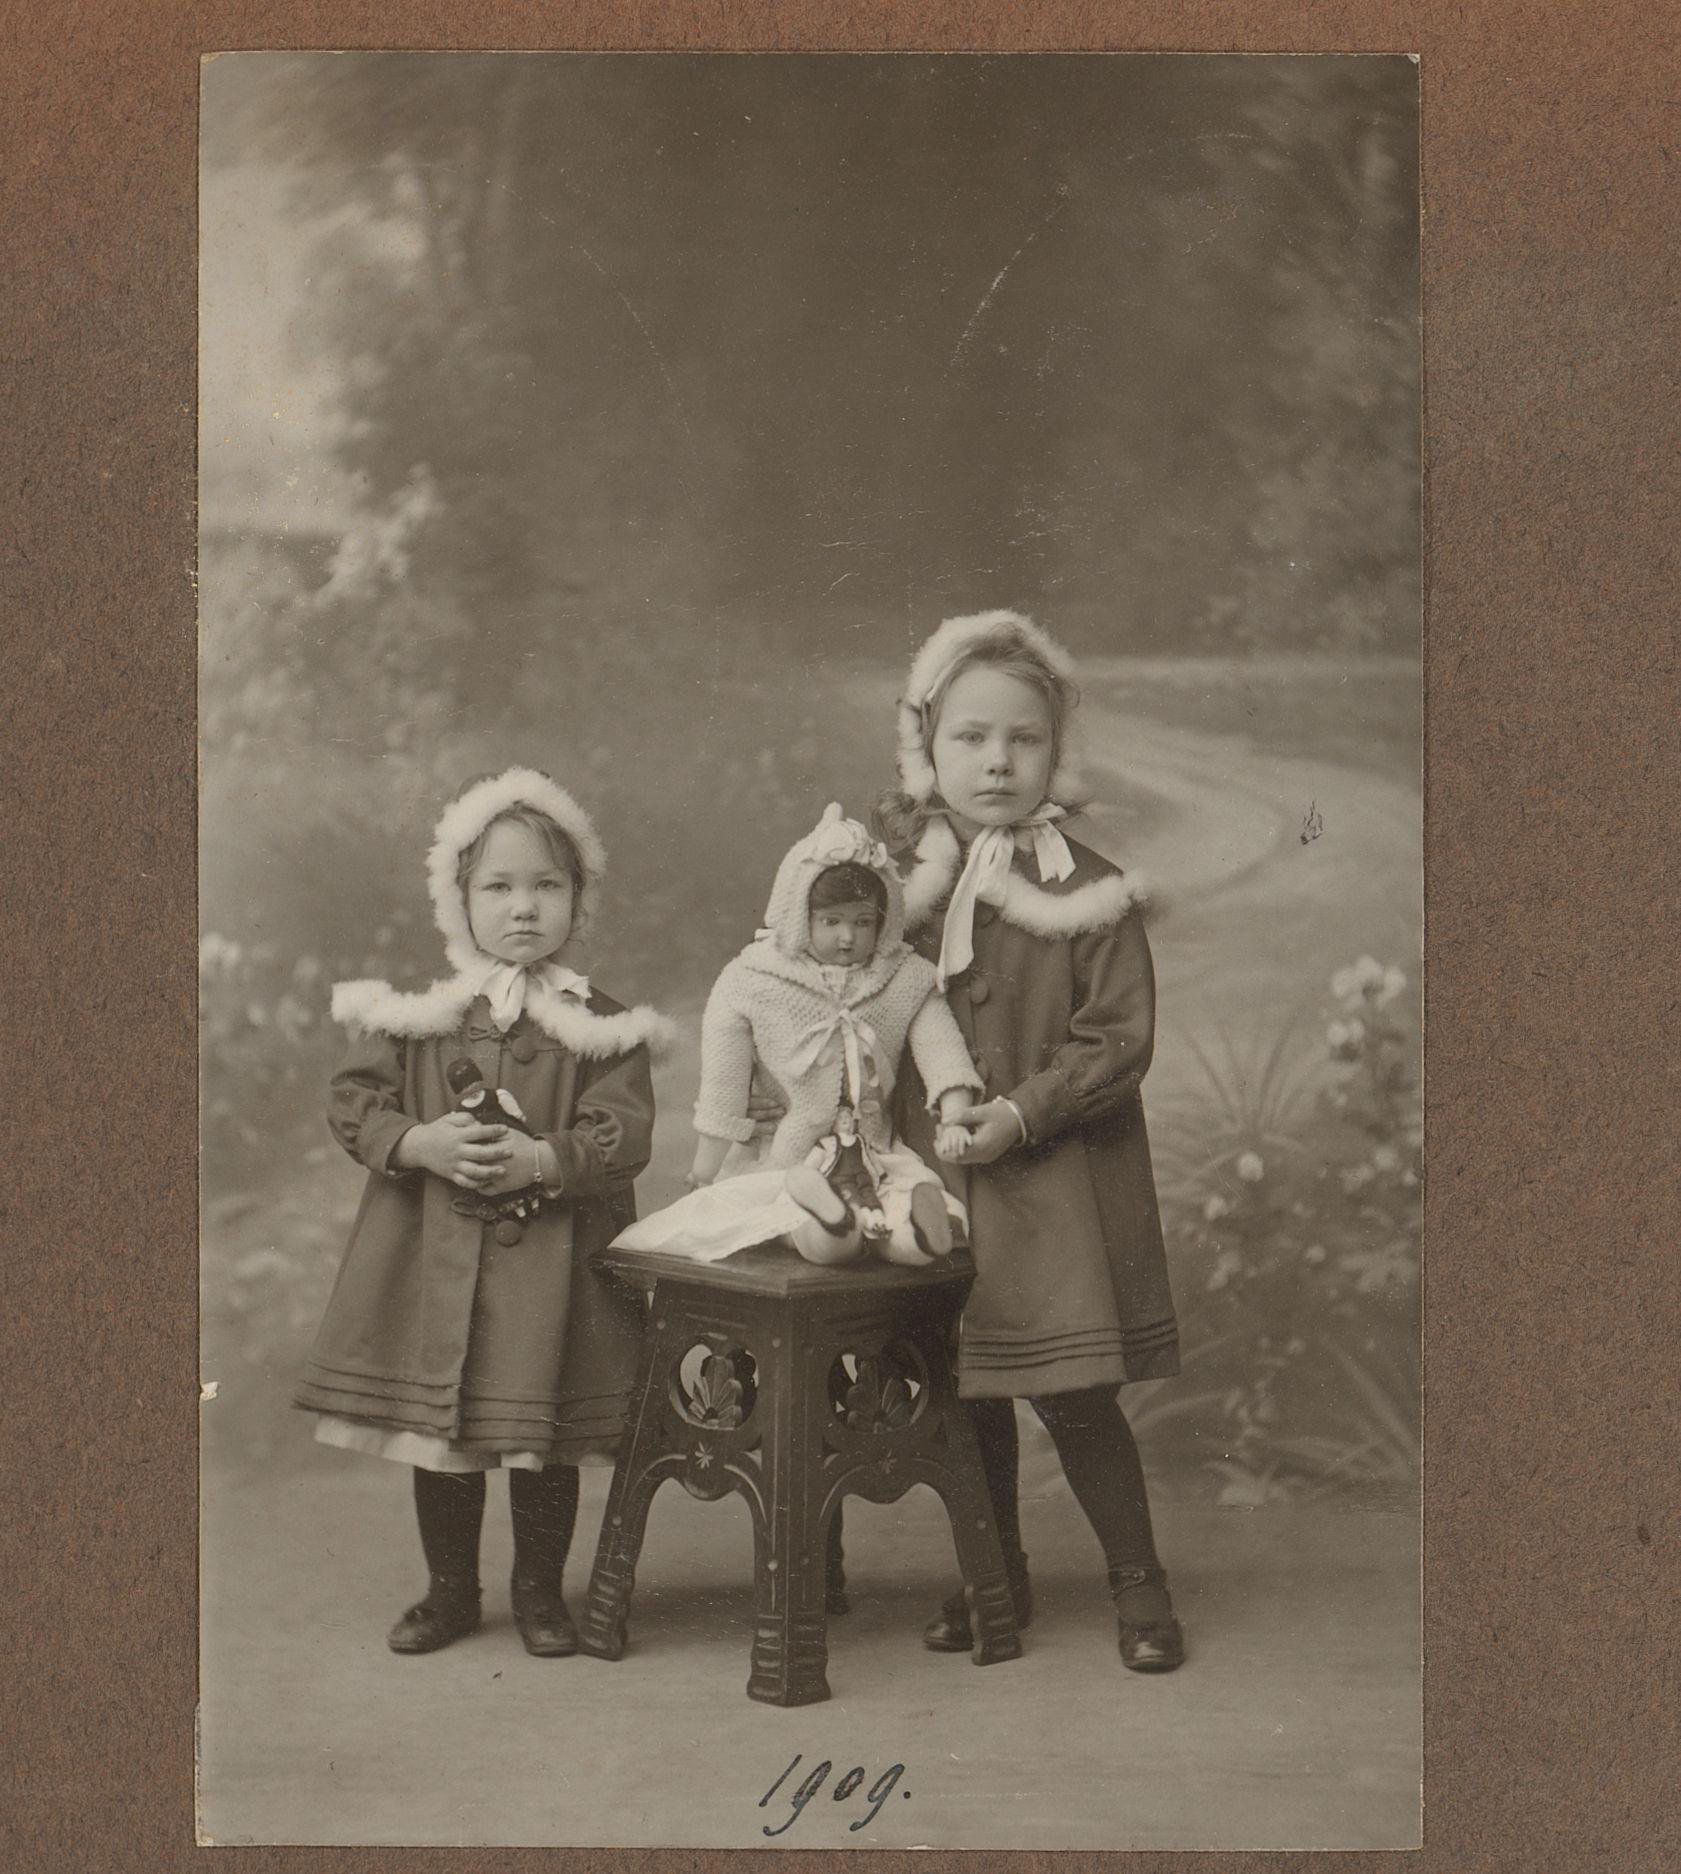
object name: photograph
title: Studioportret Thea en Joanna Diepenbrock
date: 1909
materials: photographic support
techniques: photography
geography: amsterdam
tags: amsterdam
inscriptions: inscription: ‘1909’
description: Foto op bruin albumblad 17 van familiealbum van Alphons Diepenbrock.